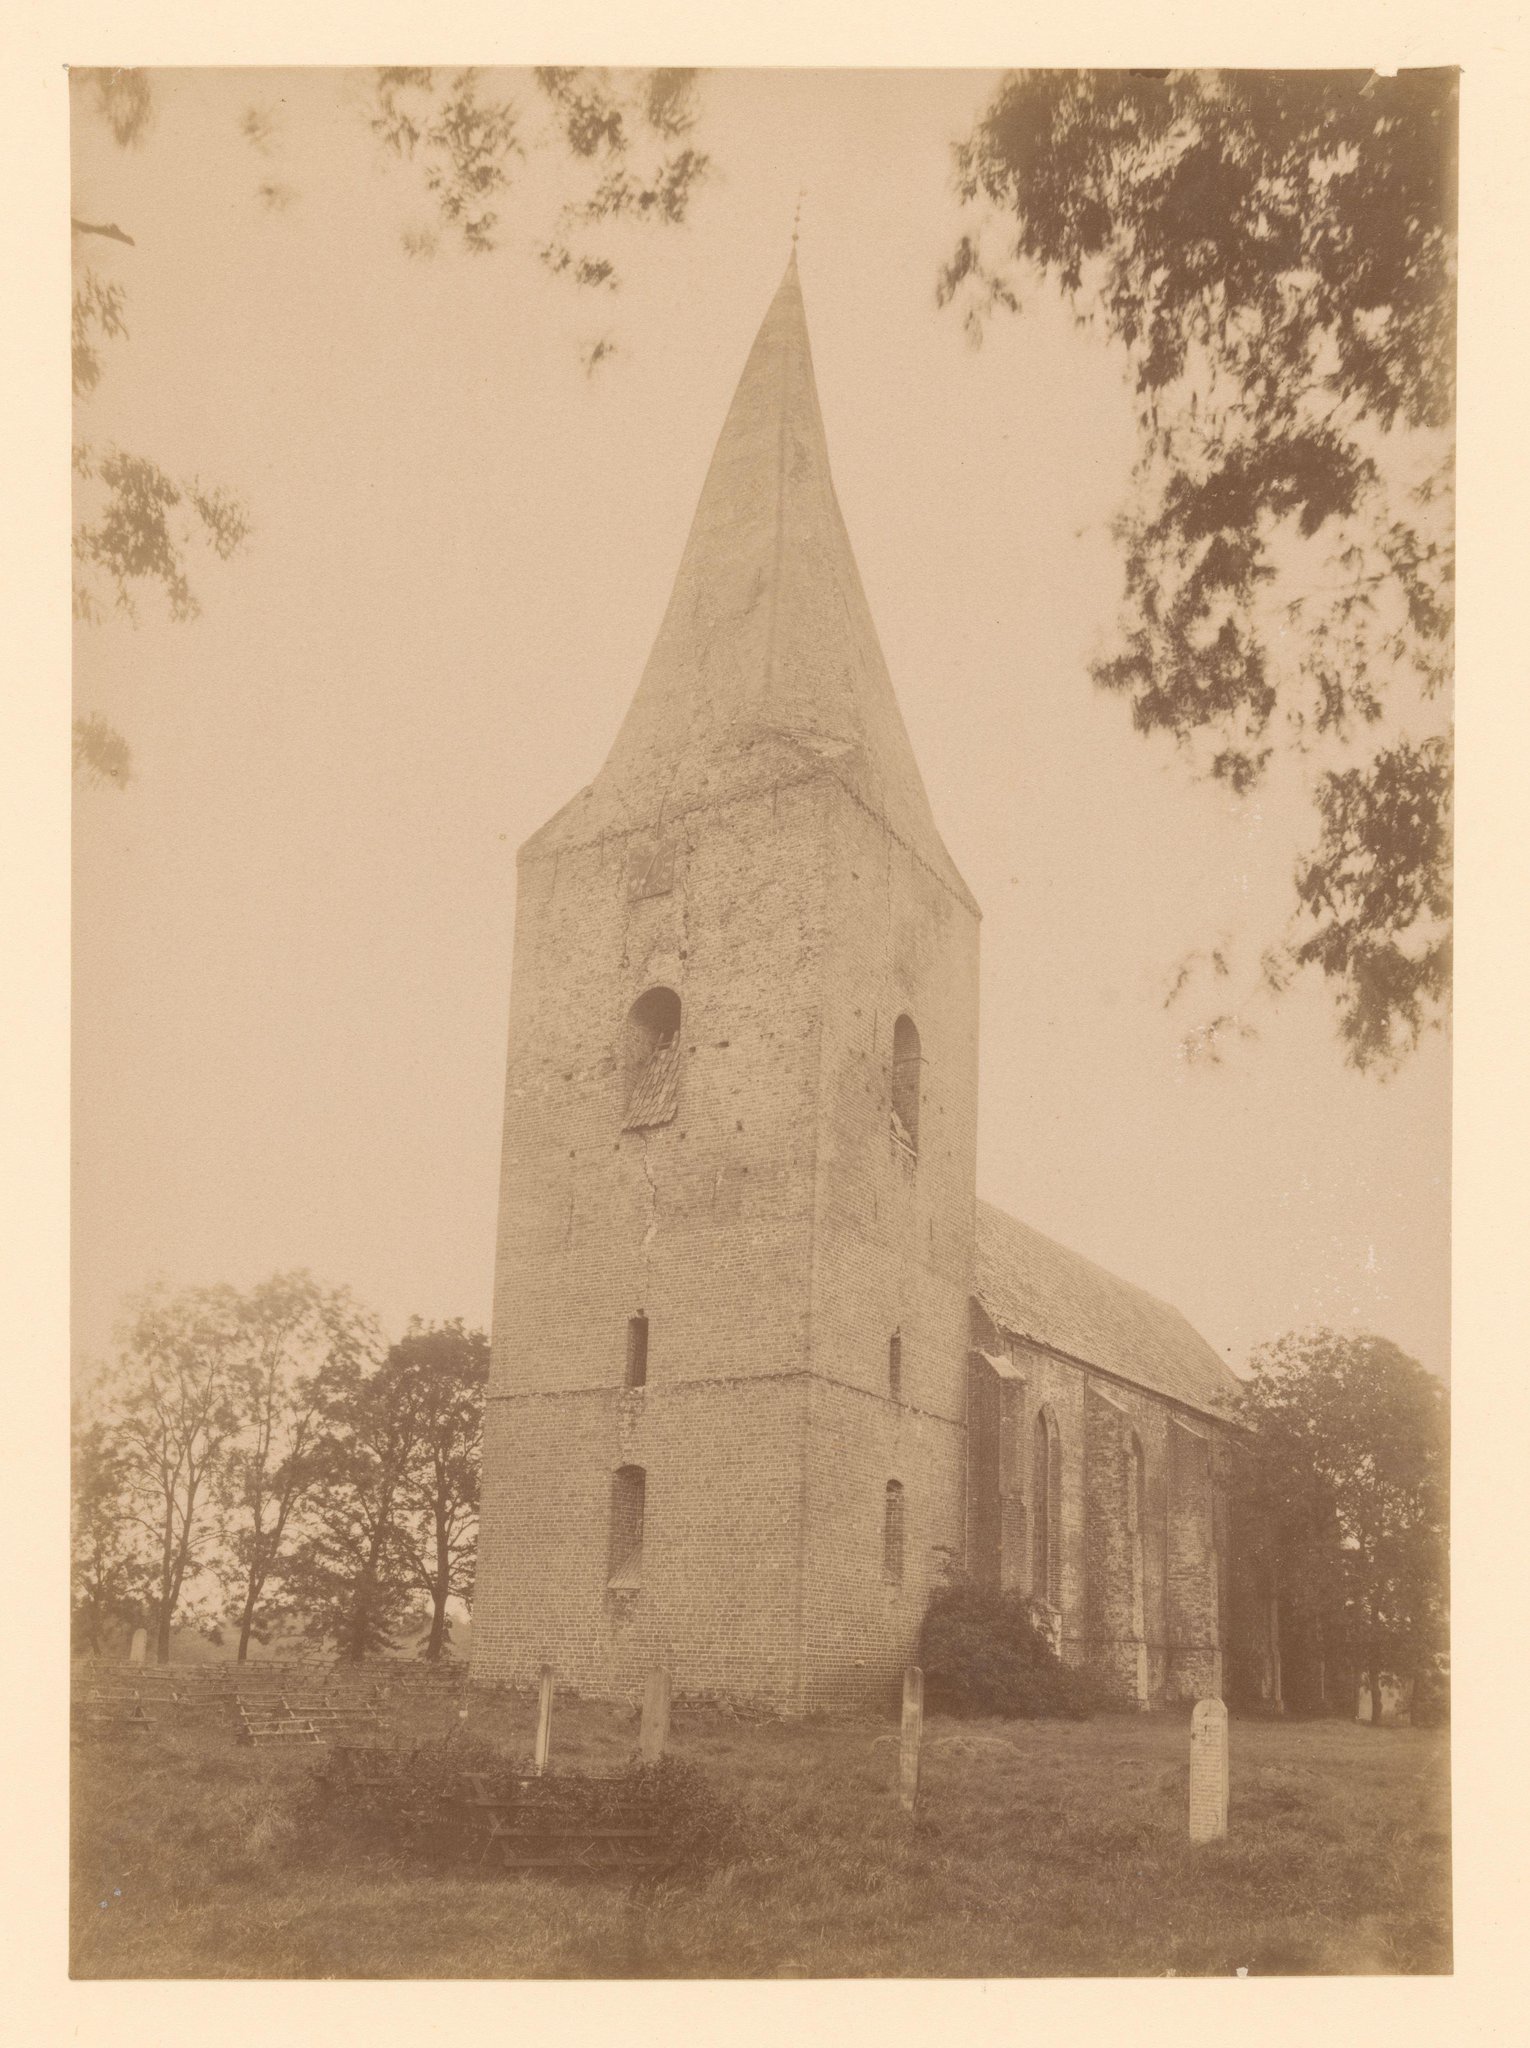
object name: photograph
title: Gezicht op de Nicolaaskerk te Onstwedde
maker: anoniem (monumentenzorg)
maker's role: fotograaf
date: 1893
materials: cardboard, photographic support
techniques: albumen print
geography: onstwedde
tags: church (exterior)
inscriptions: annotation: ‘Onstwedde/ Toren aan de kerk van de N.H. kerk/ aug 1893’, annotation: ‘Onstwedde’